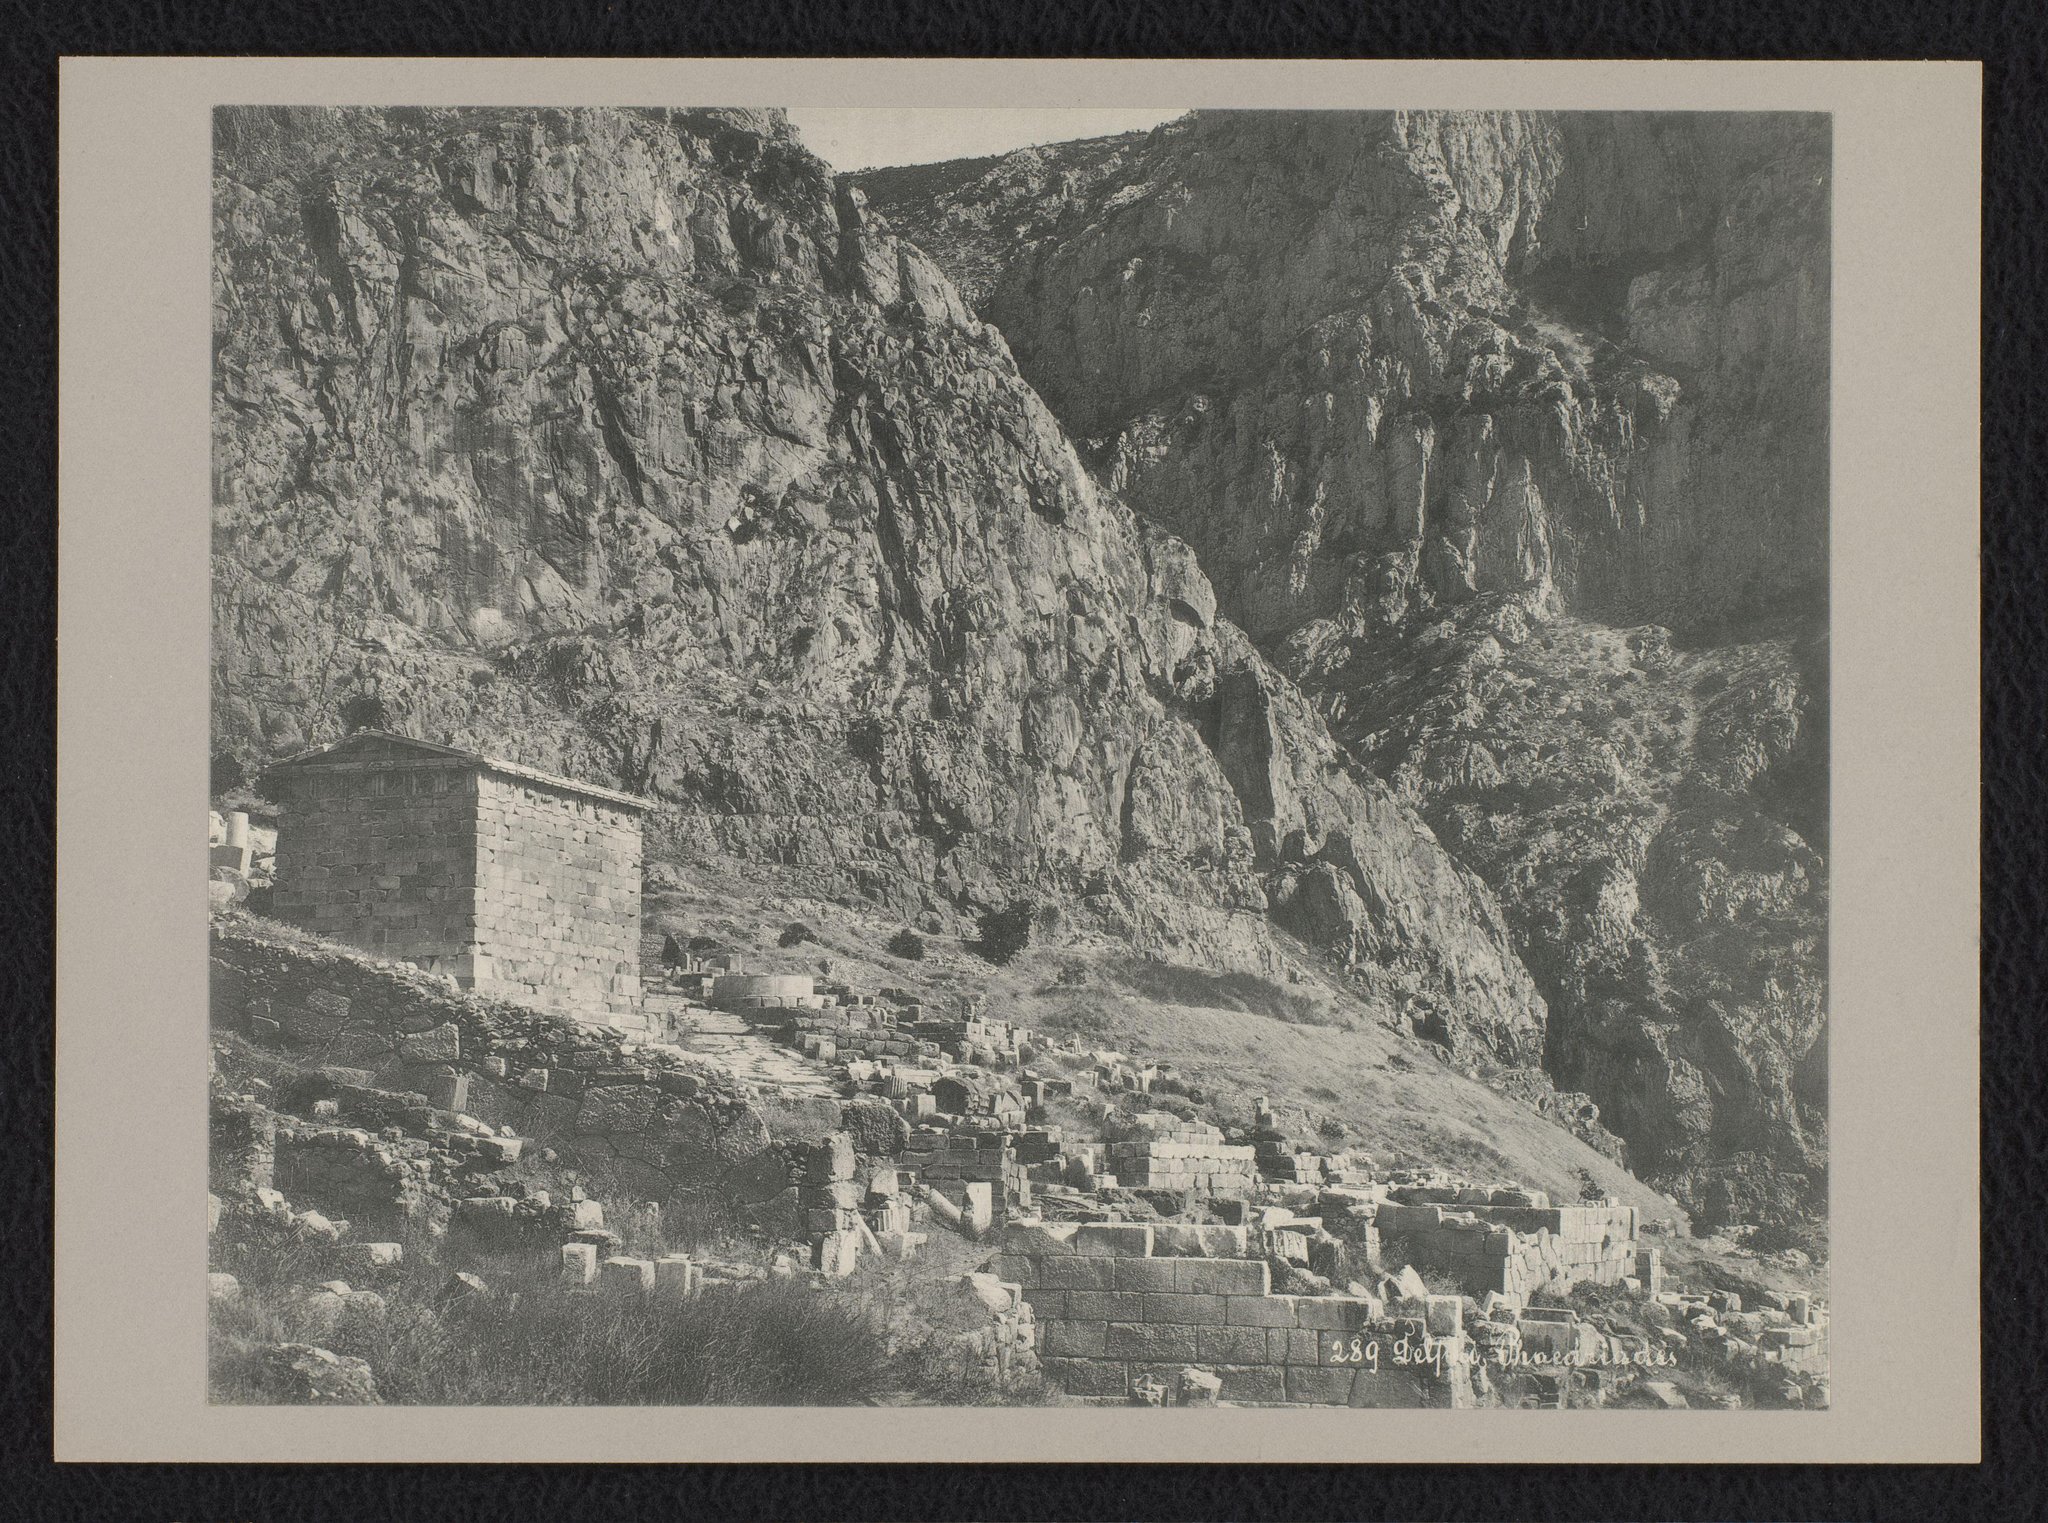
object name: photograph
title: Phaedriades bij Delphi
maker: Anonymous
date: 1895-1915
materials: cardboard, paper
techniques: photograph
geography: delphi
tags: delphi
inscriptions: number: ‘15.’